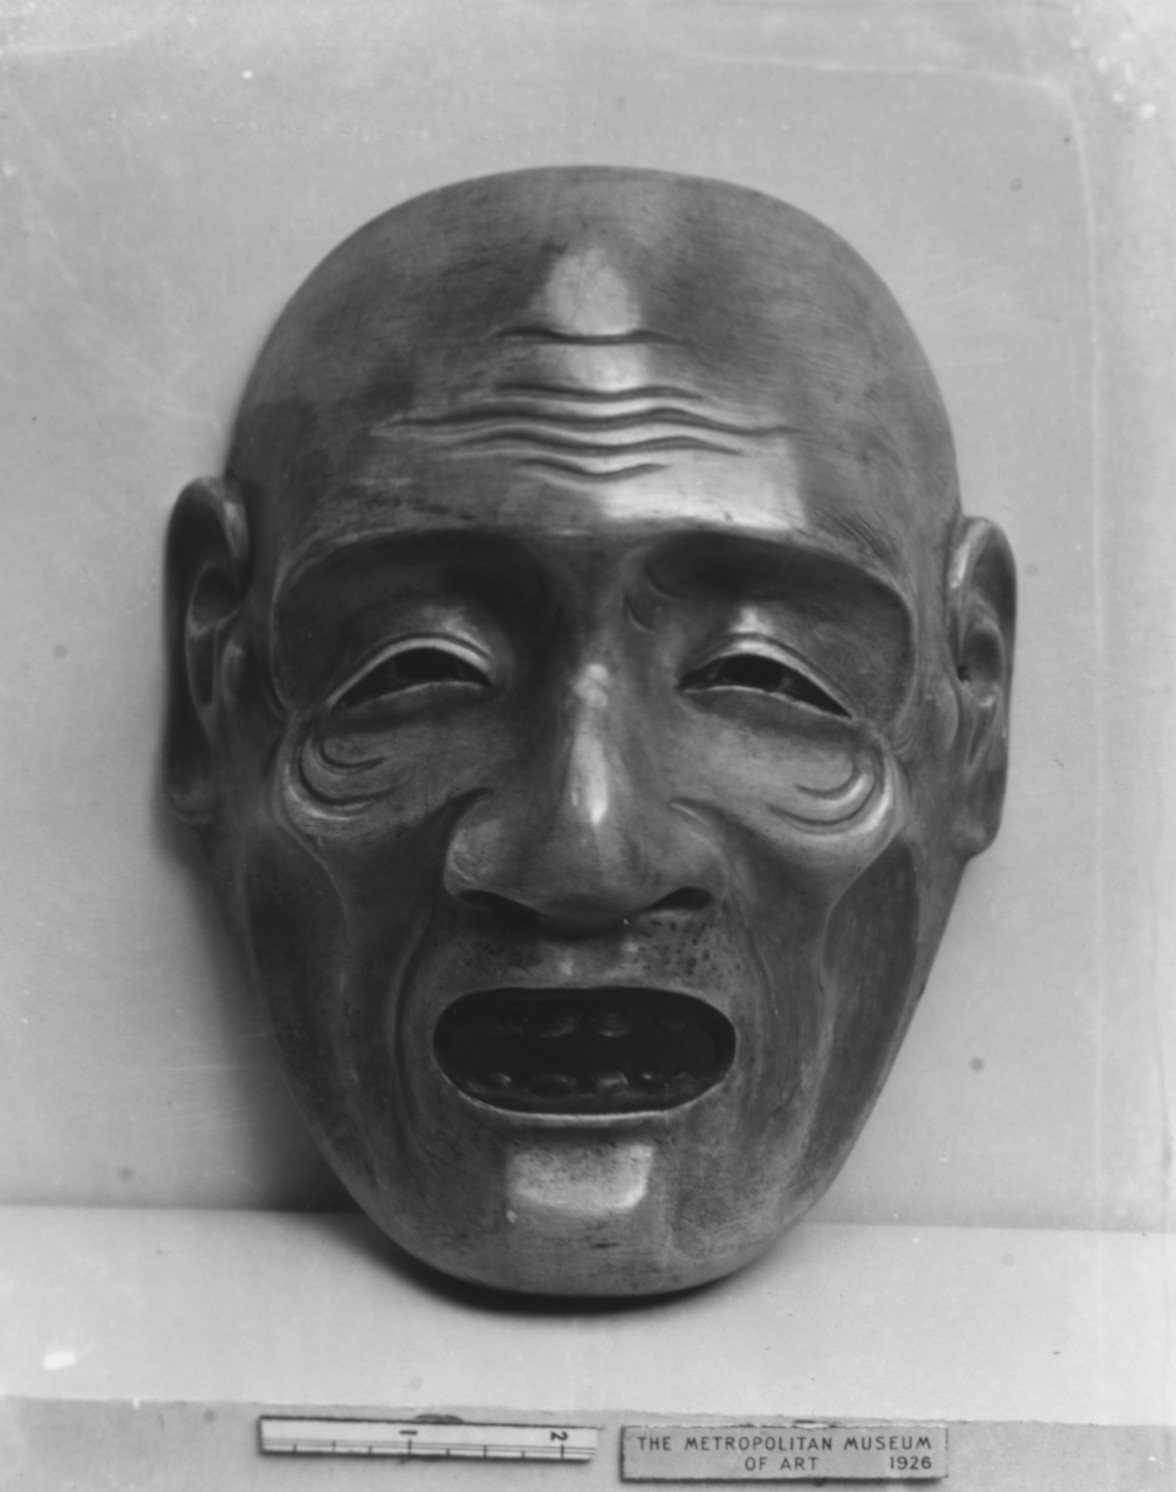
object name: kyogen mask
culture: japanese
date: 1801-1900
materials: wood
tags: masks